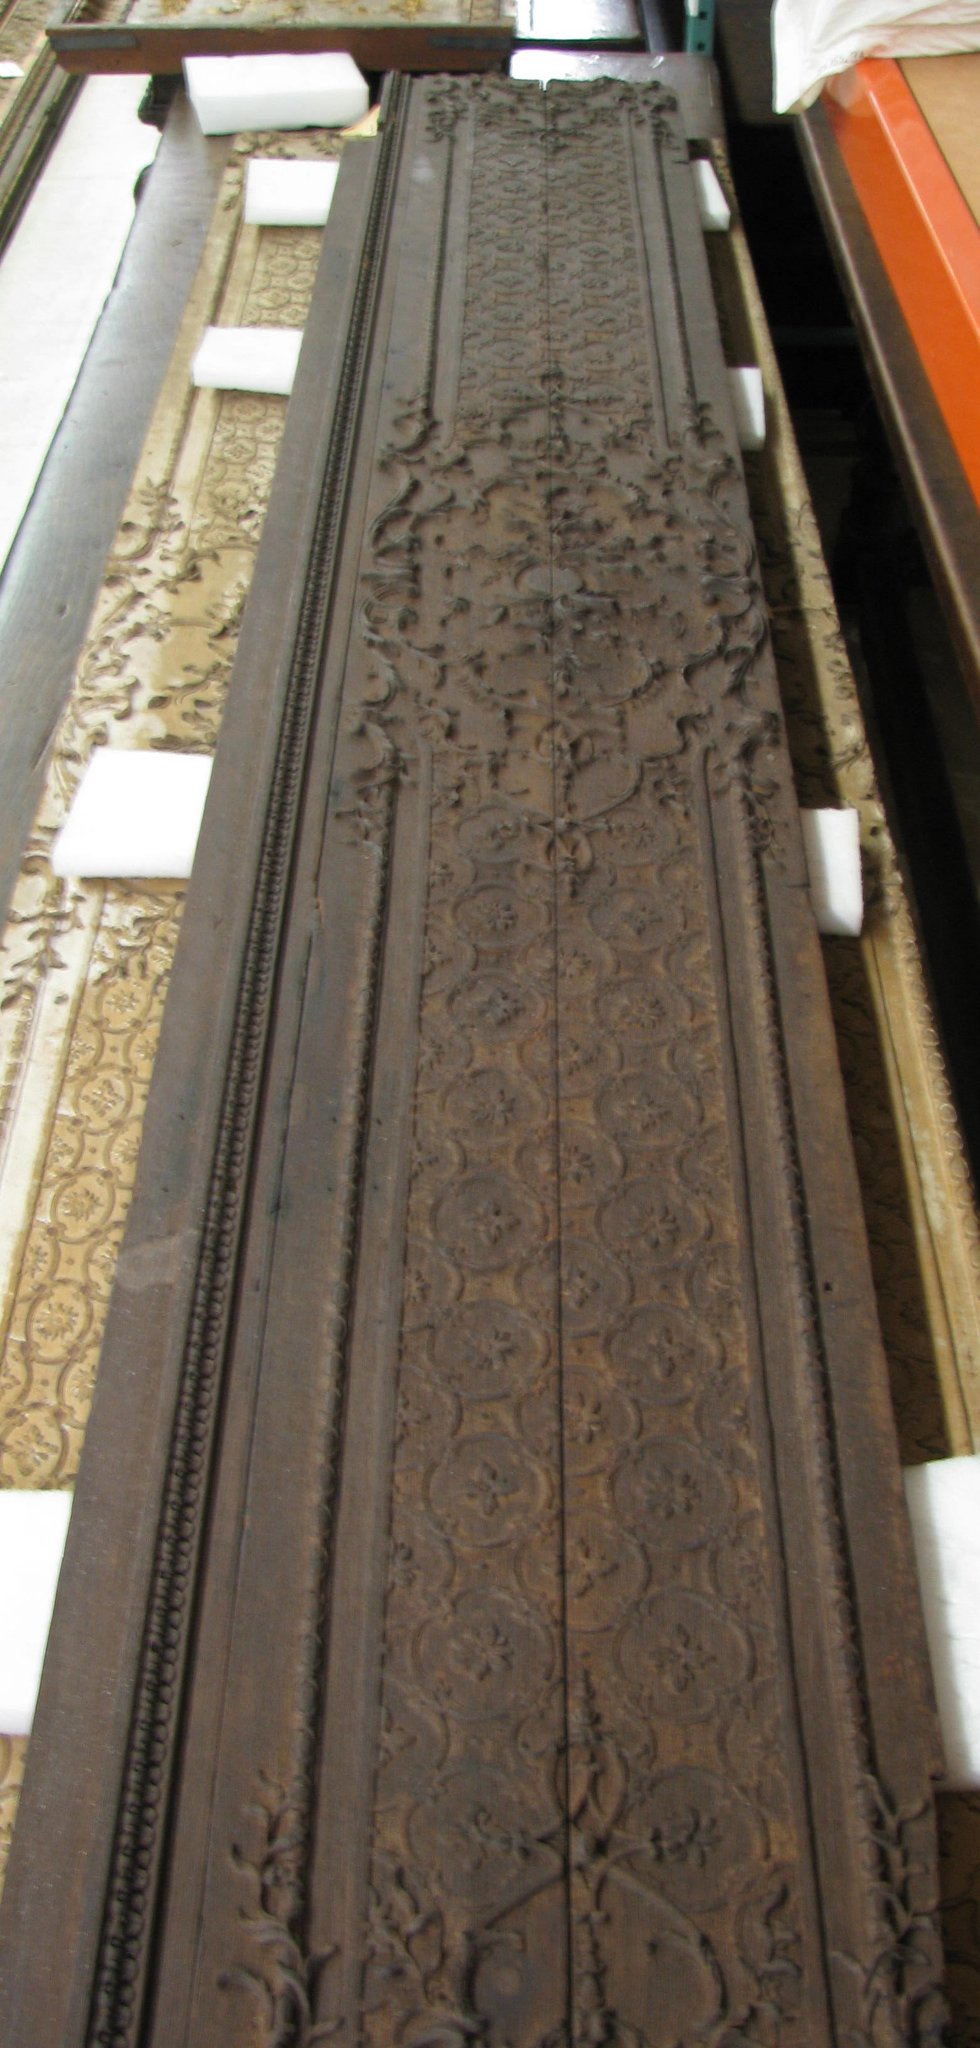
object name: pilaster panel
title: Pilaster panel possibly from the Château de Rambouillet, France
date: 1701-1800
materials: wood, paint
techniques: carving